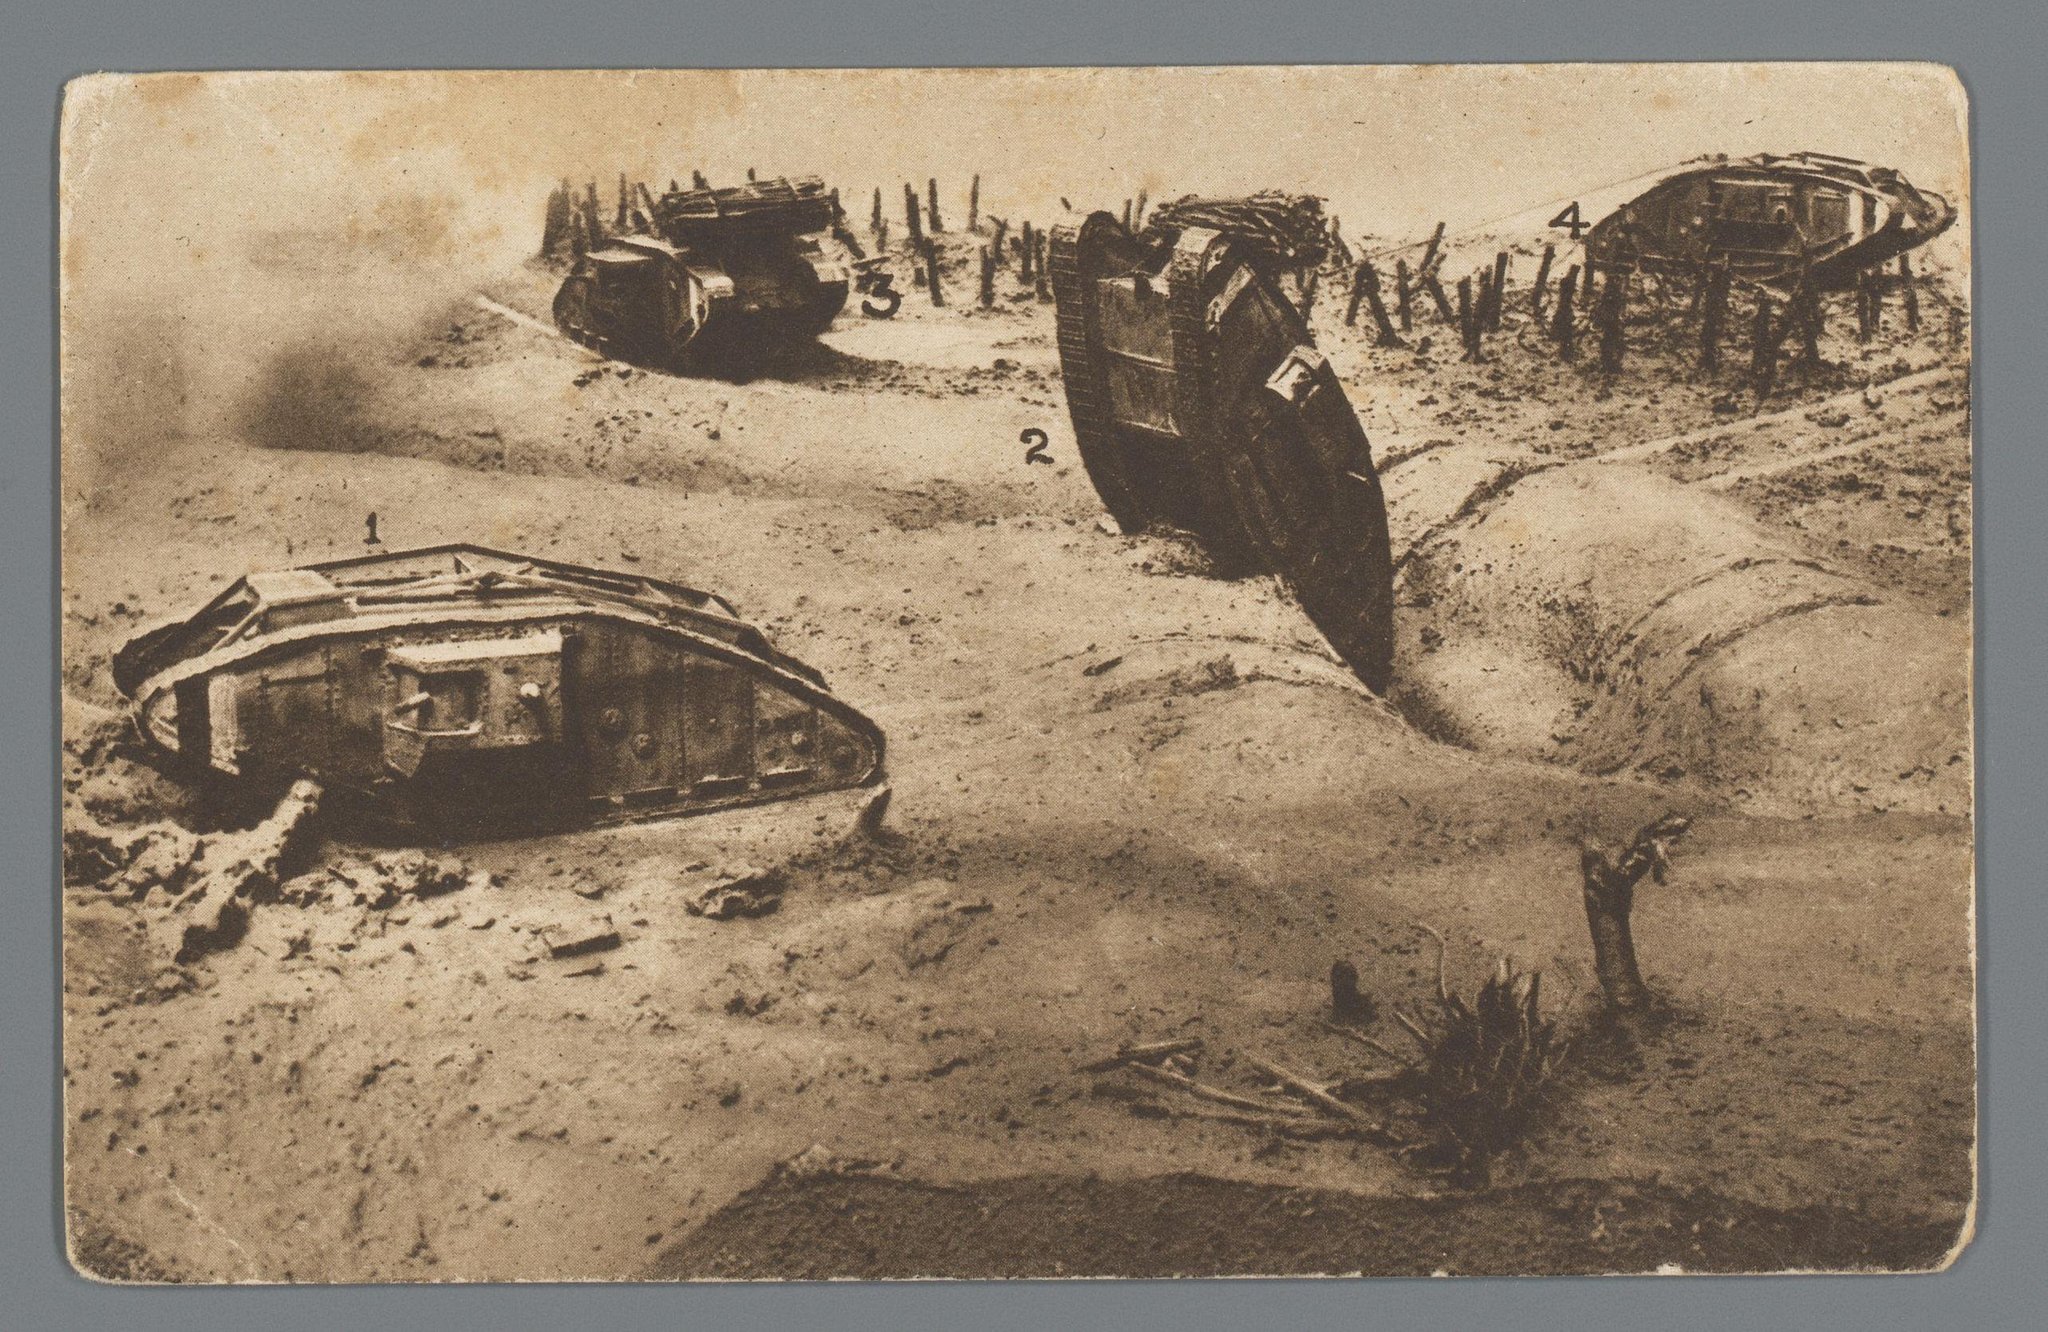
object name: photomechanical print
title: Vier tanks op een slagveld tijdens de Eerste Wereldoorlog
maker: Anonymous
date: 1918-1970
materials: paper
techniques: rotogravure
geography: great britain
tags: modern forms of military vehicles (tank)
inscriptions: inscription: ‘Crown Copyright in letterpress and illustrations reserved.’, inscription: ‘The Germans/ intended their trenches to be so wide and/ deep as to be impassable. But our Tanks carried/ fascines (large faggots), with which to fill up (...)’